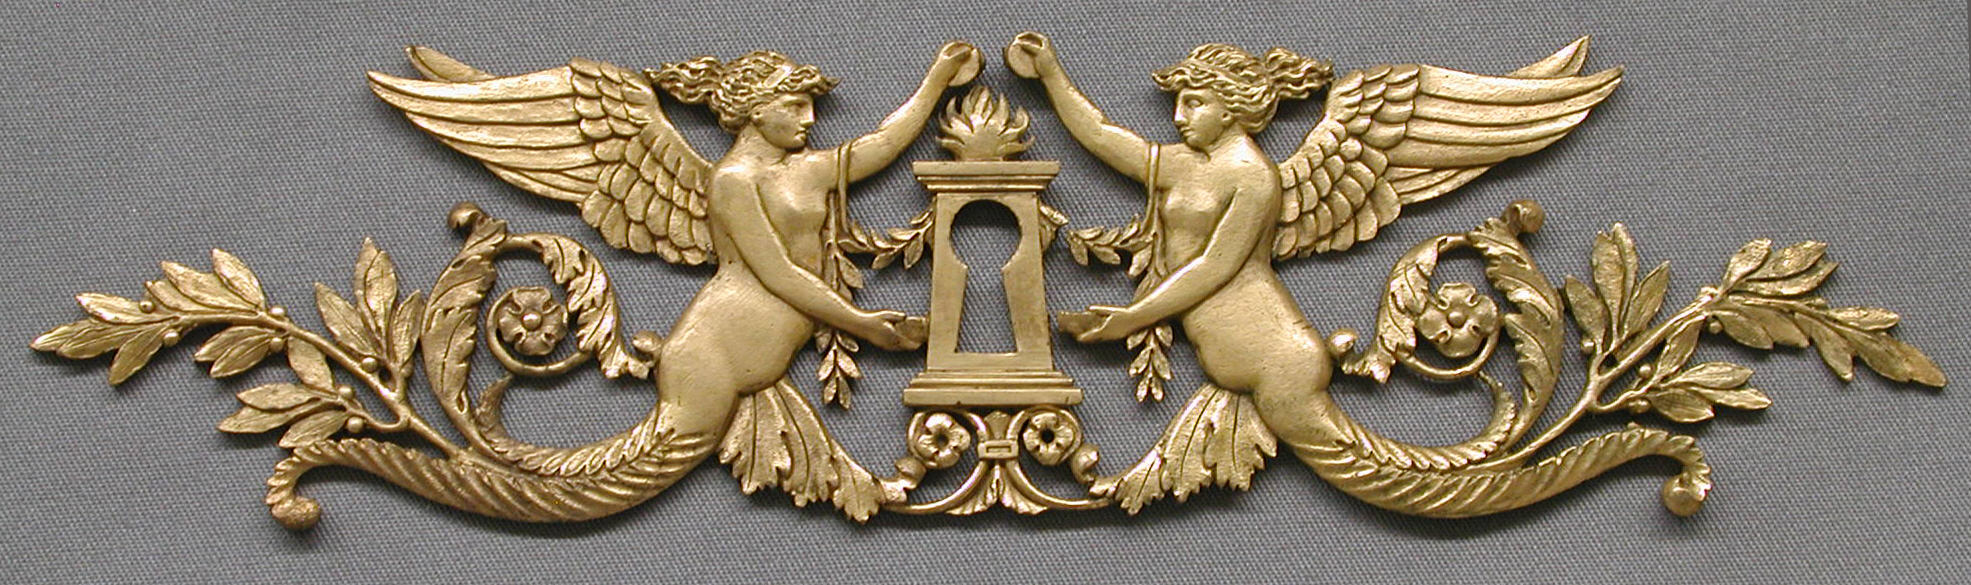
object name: keyhole escutcheon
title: Pair of keyhole escutcheons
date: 1801-1900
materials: gilt bronze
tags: coat of arms